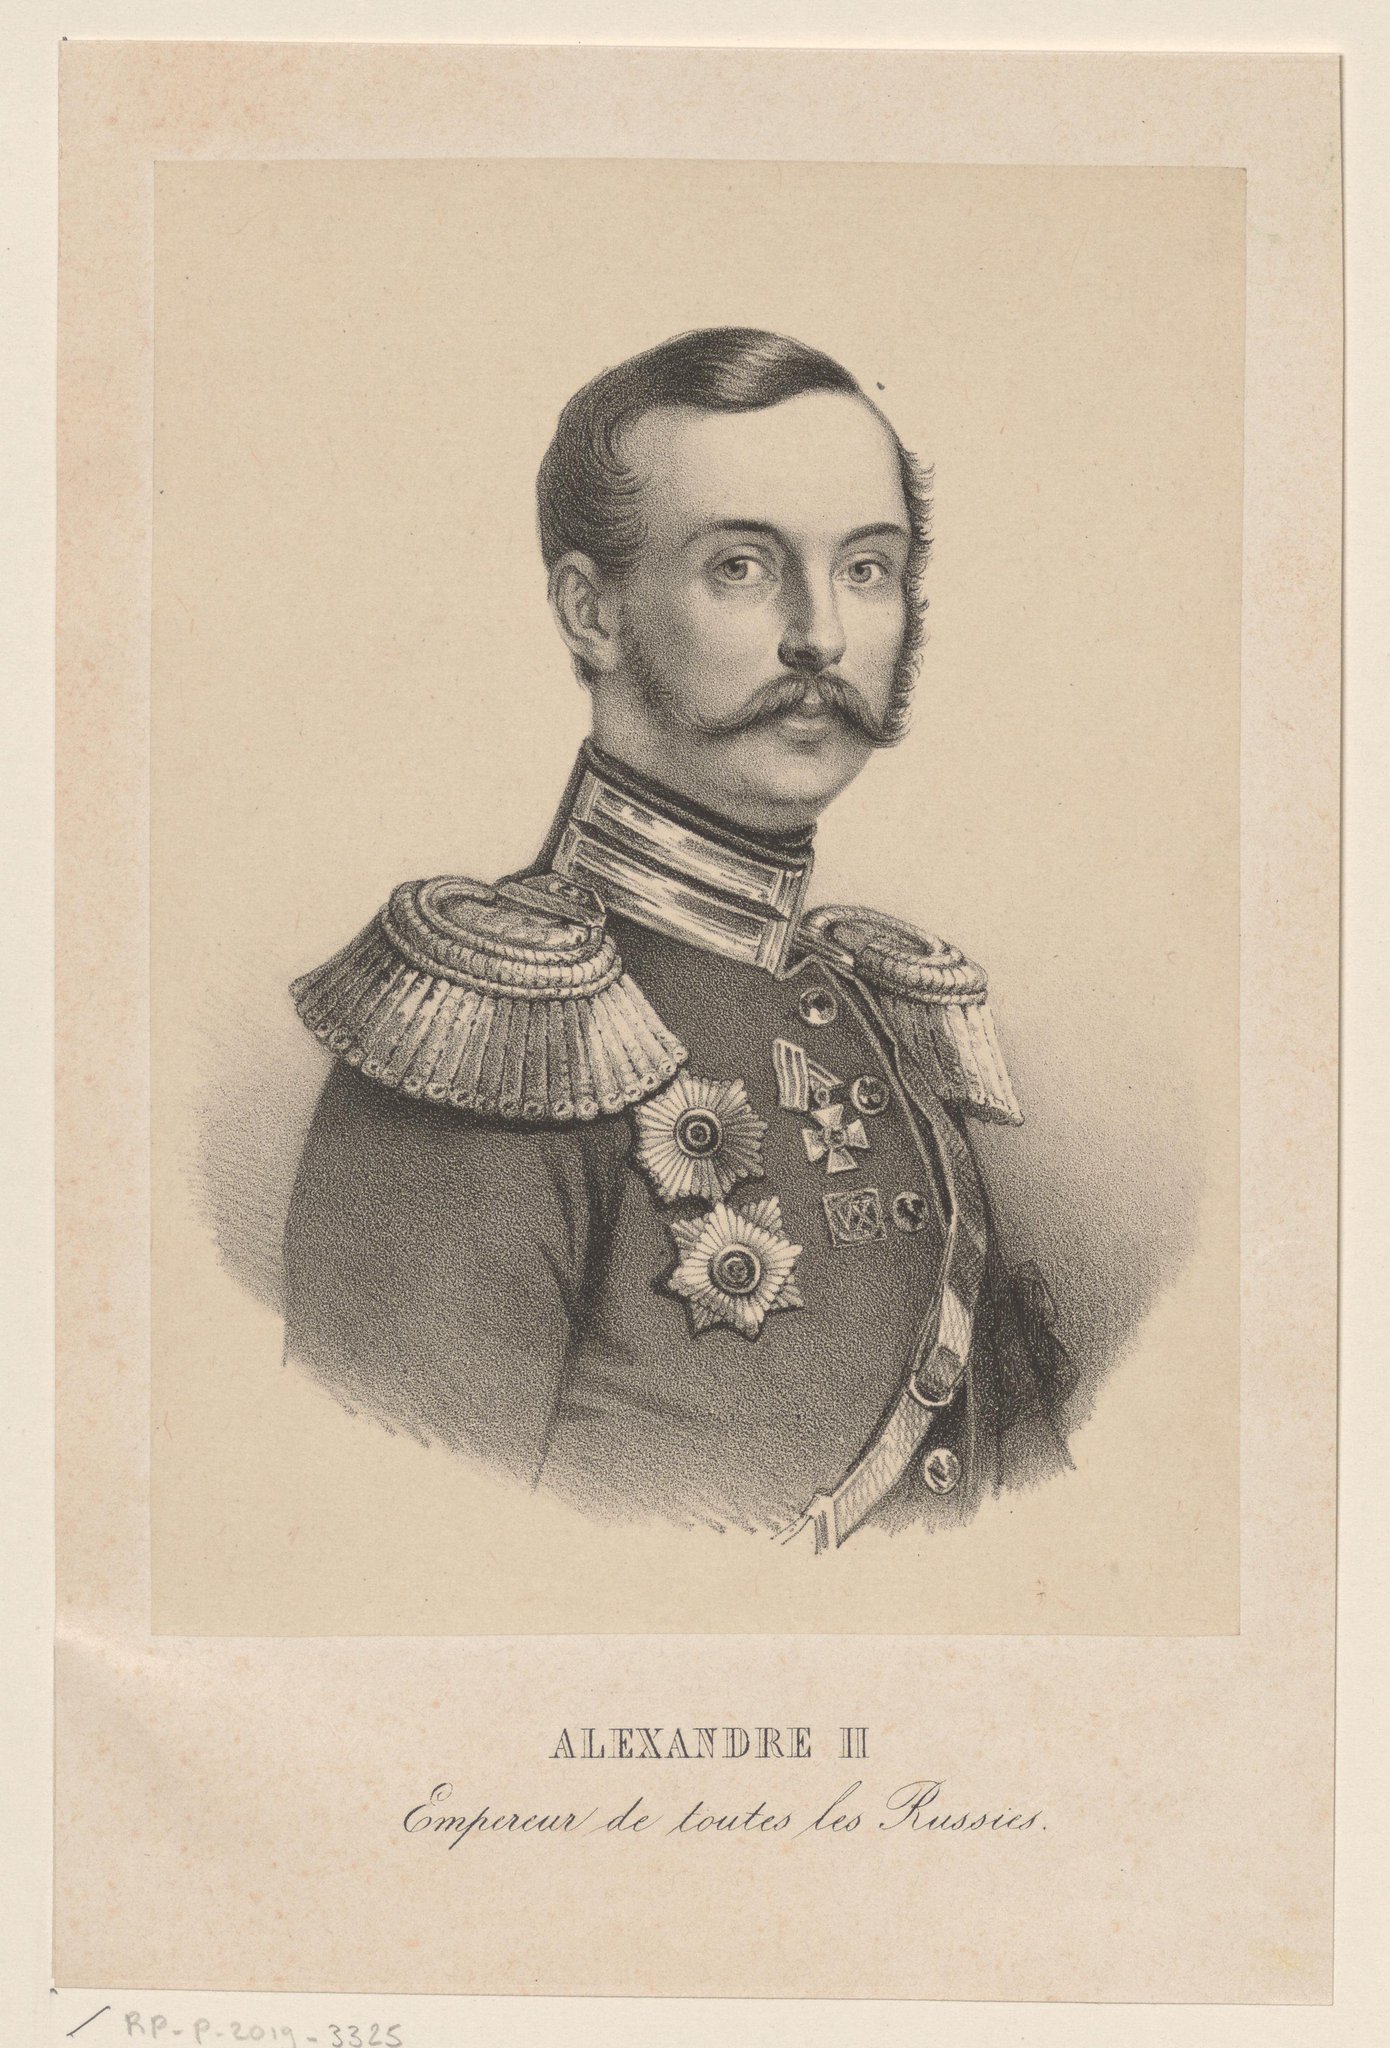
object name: print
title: Portret van Alexander II, tsaar van Rusland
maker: Anonymous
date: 1855-1899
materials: paper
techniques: lithograph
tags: historical persons, emperor